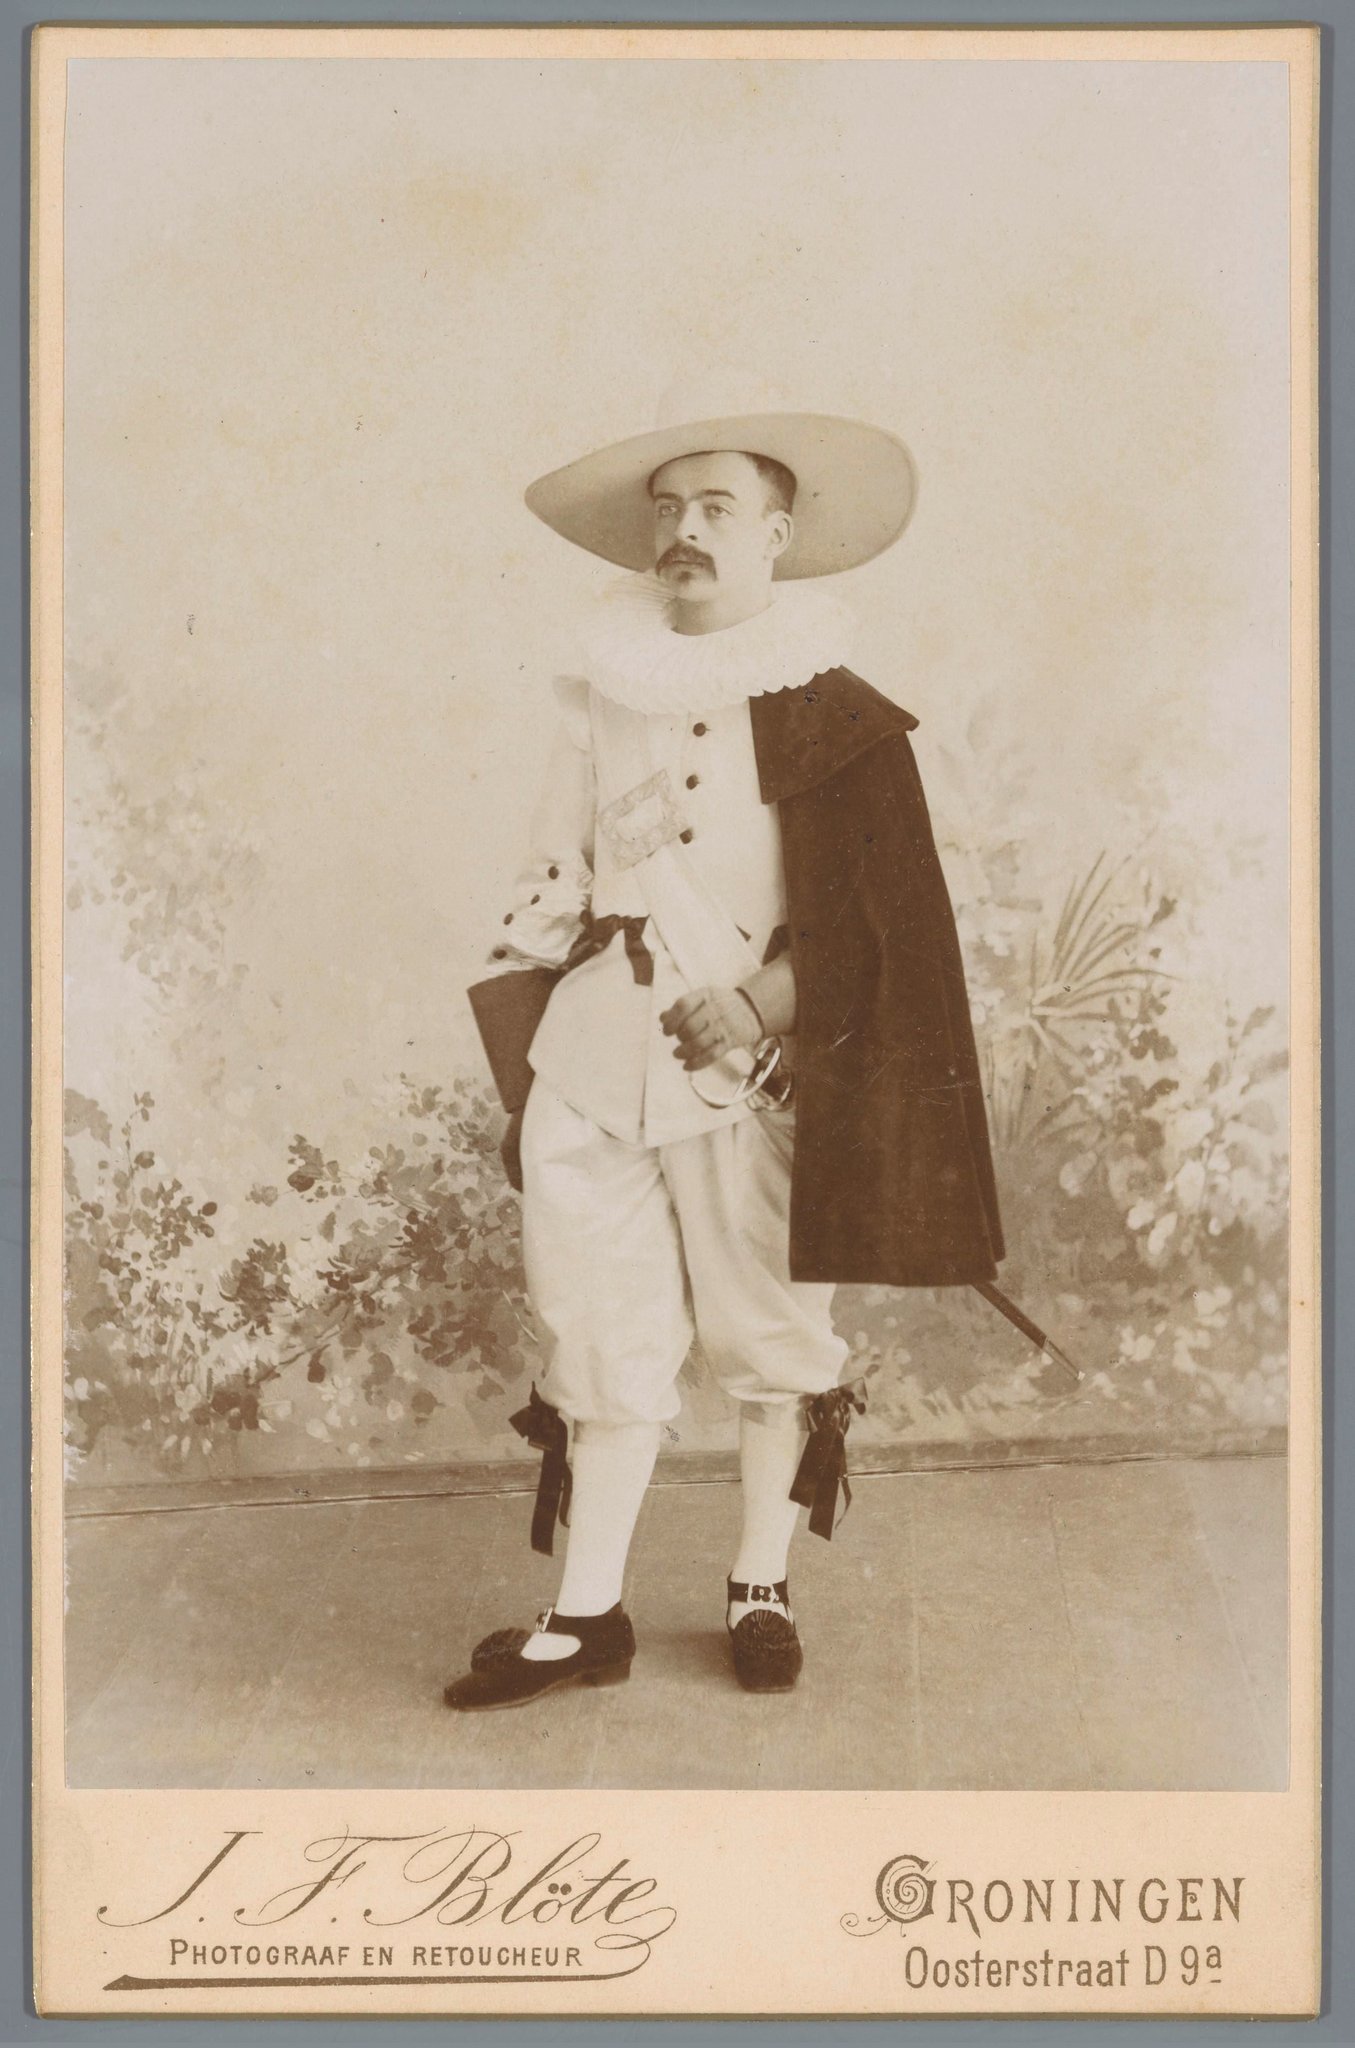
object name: cabinet photograph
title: Portret van een Groningse student in maskeradekostuum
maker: jan frederik blöte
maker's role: fotograaf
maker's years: 1865-1956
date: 1890-1900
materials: photographic support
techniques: collodion silver print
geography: groningen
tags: students' pageant, costumes used in pageants